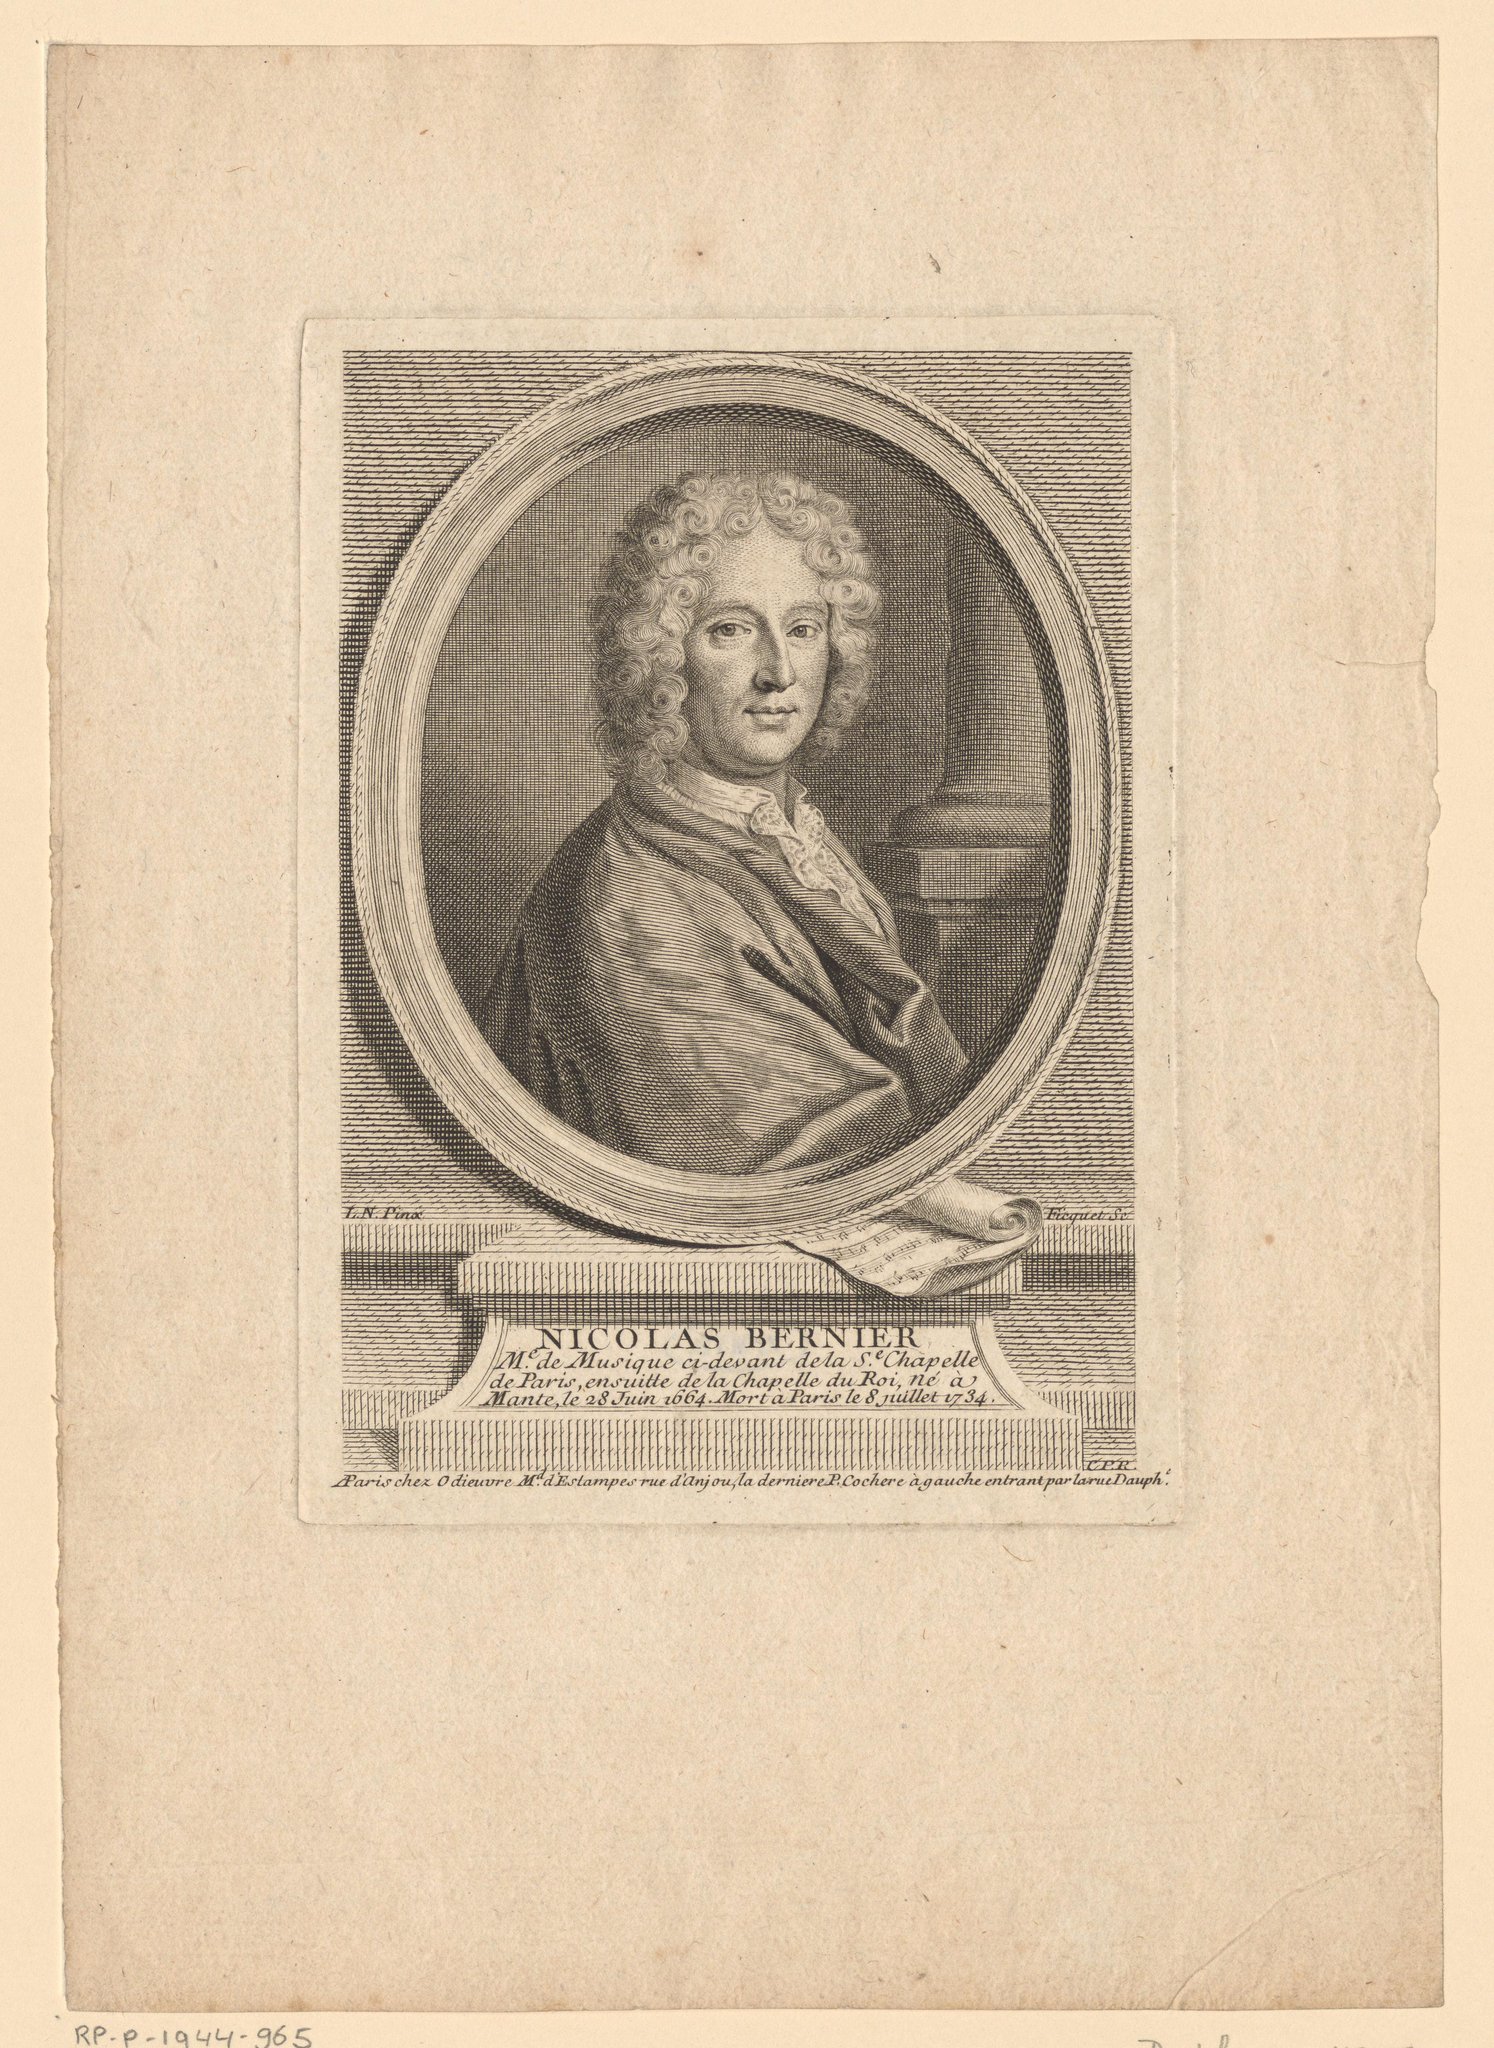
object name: print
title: Portret van Nicolas Bernier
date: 1741-1747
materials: paper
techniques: engraving, etching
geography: paris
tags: notation of music, historical persons, portrait of composer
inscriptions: collector's mark: Lugt 2228